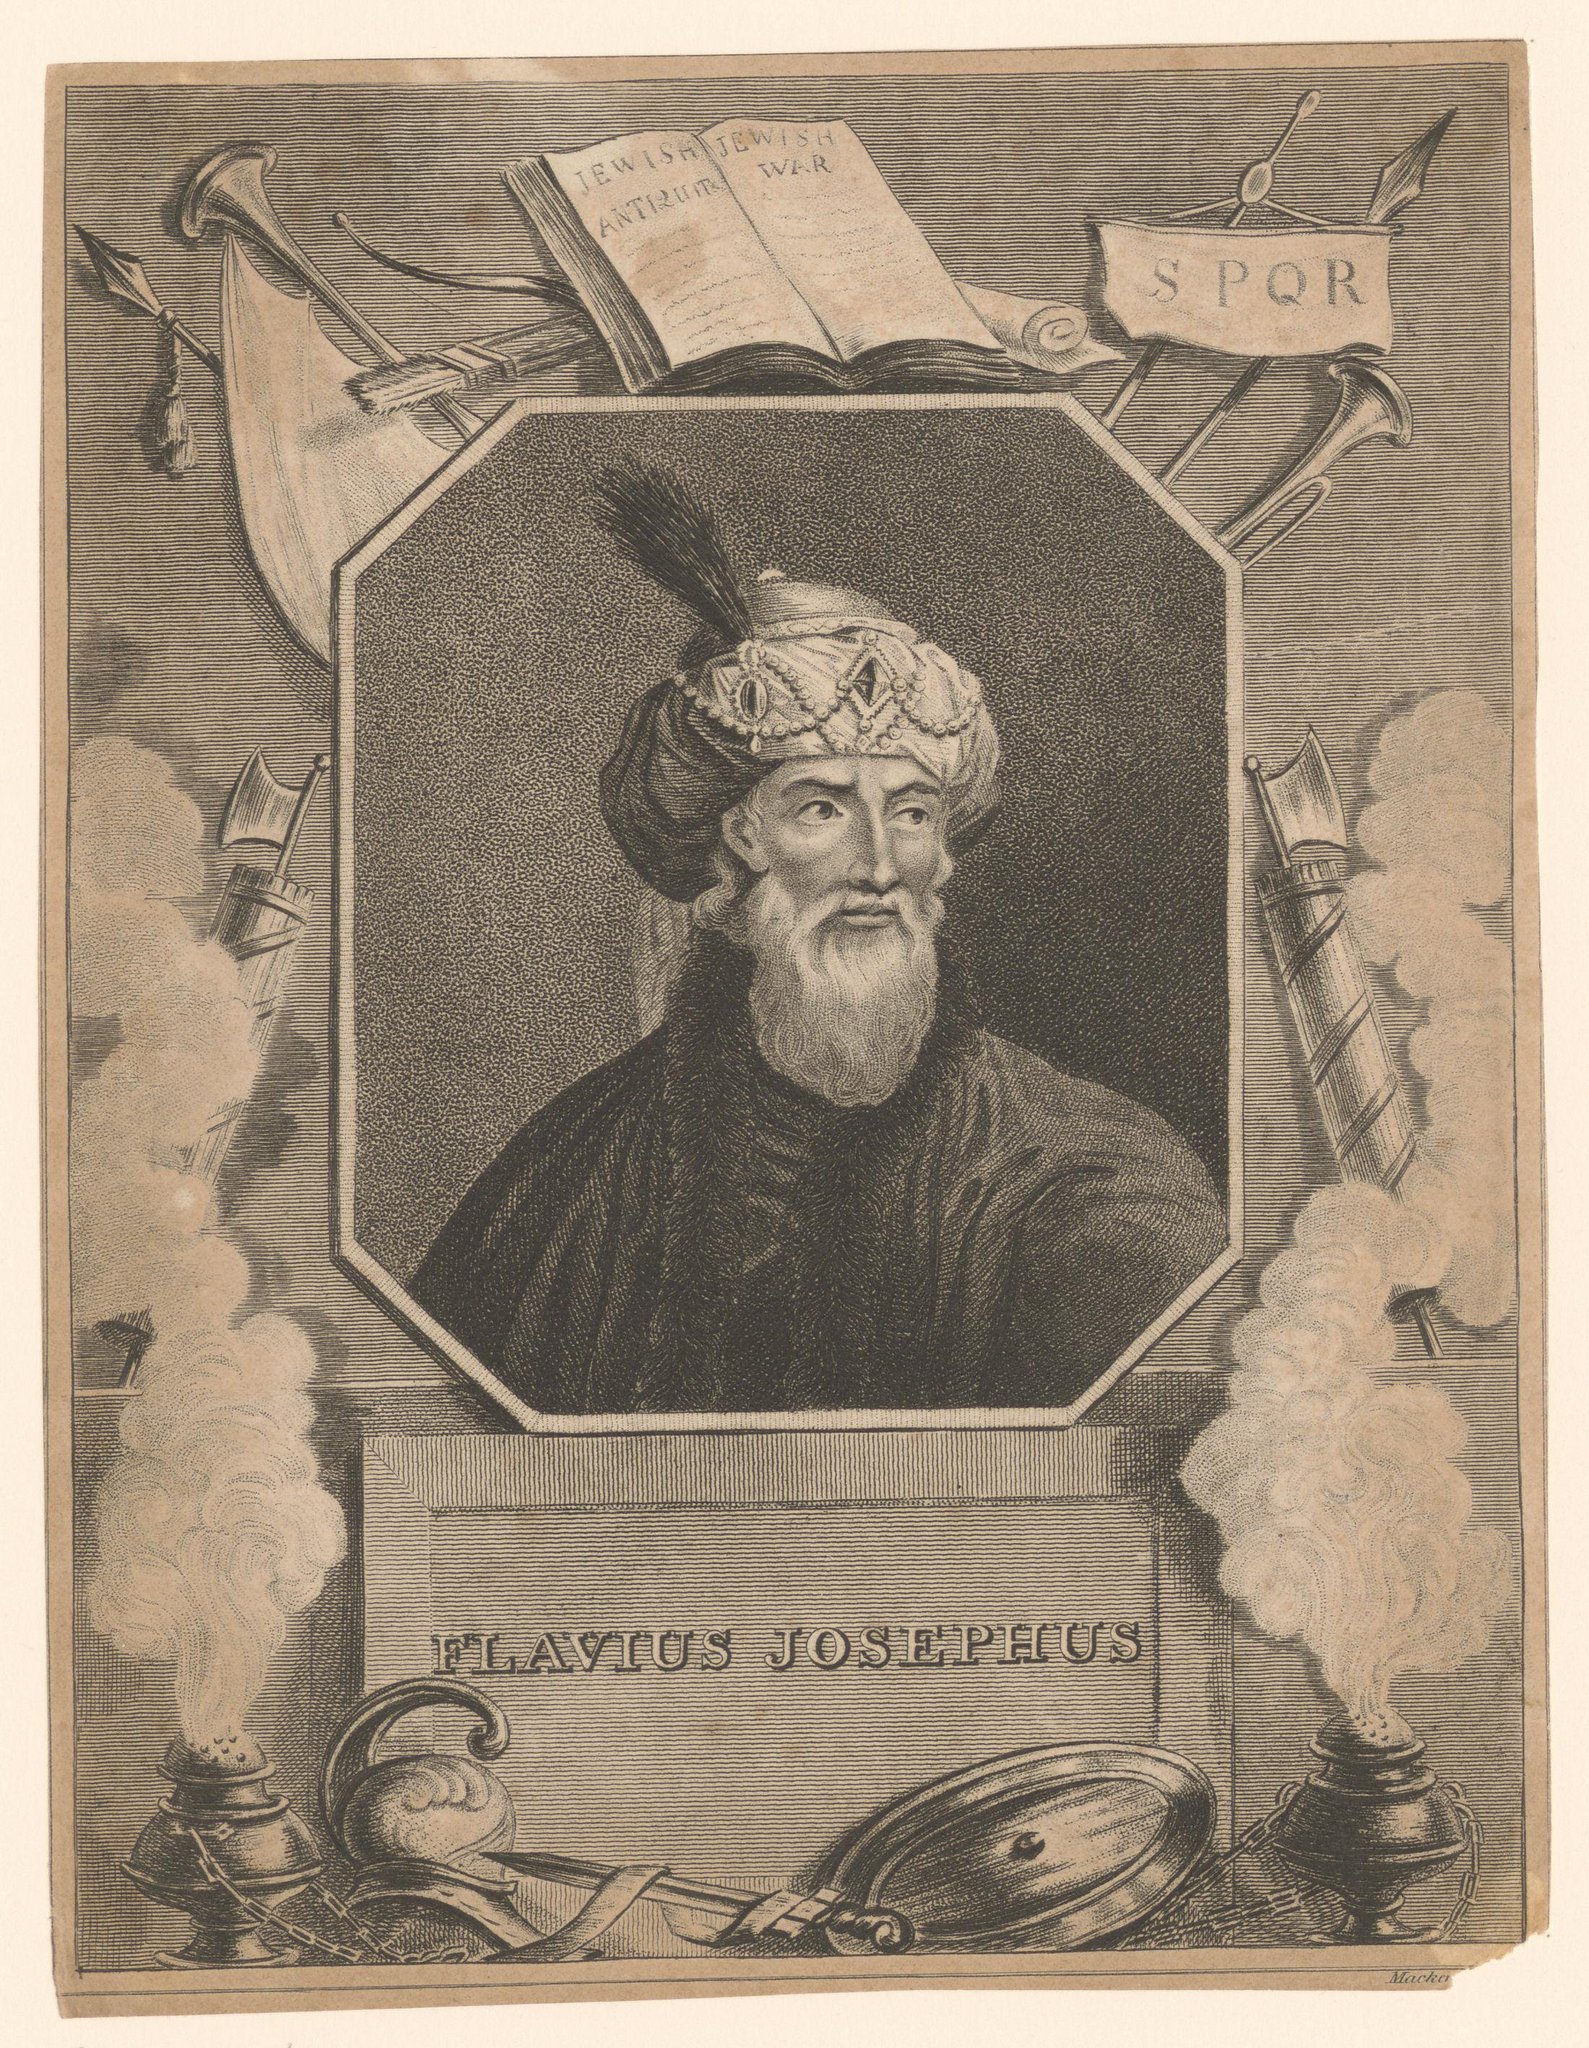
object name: print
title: Portret van Flavius Josephus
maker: k. mackenzie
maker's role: print maker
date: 1750-1850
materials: paper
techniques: etching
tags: historical persons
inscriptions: collector's mark: Lugt 2228